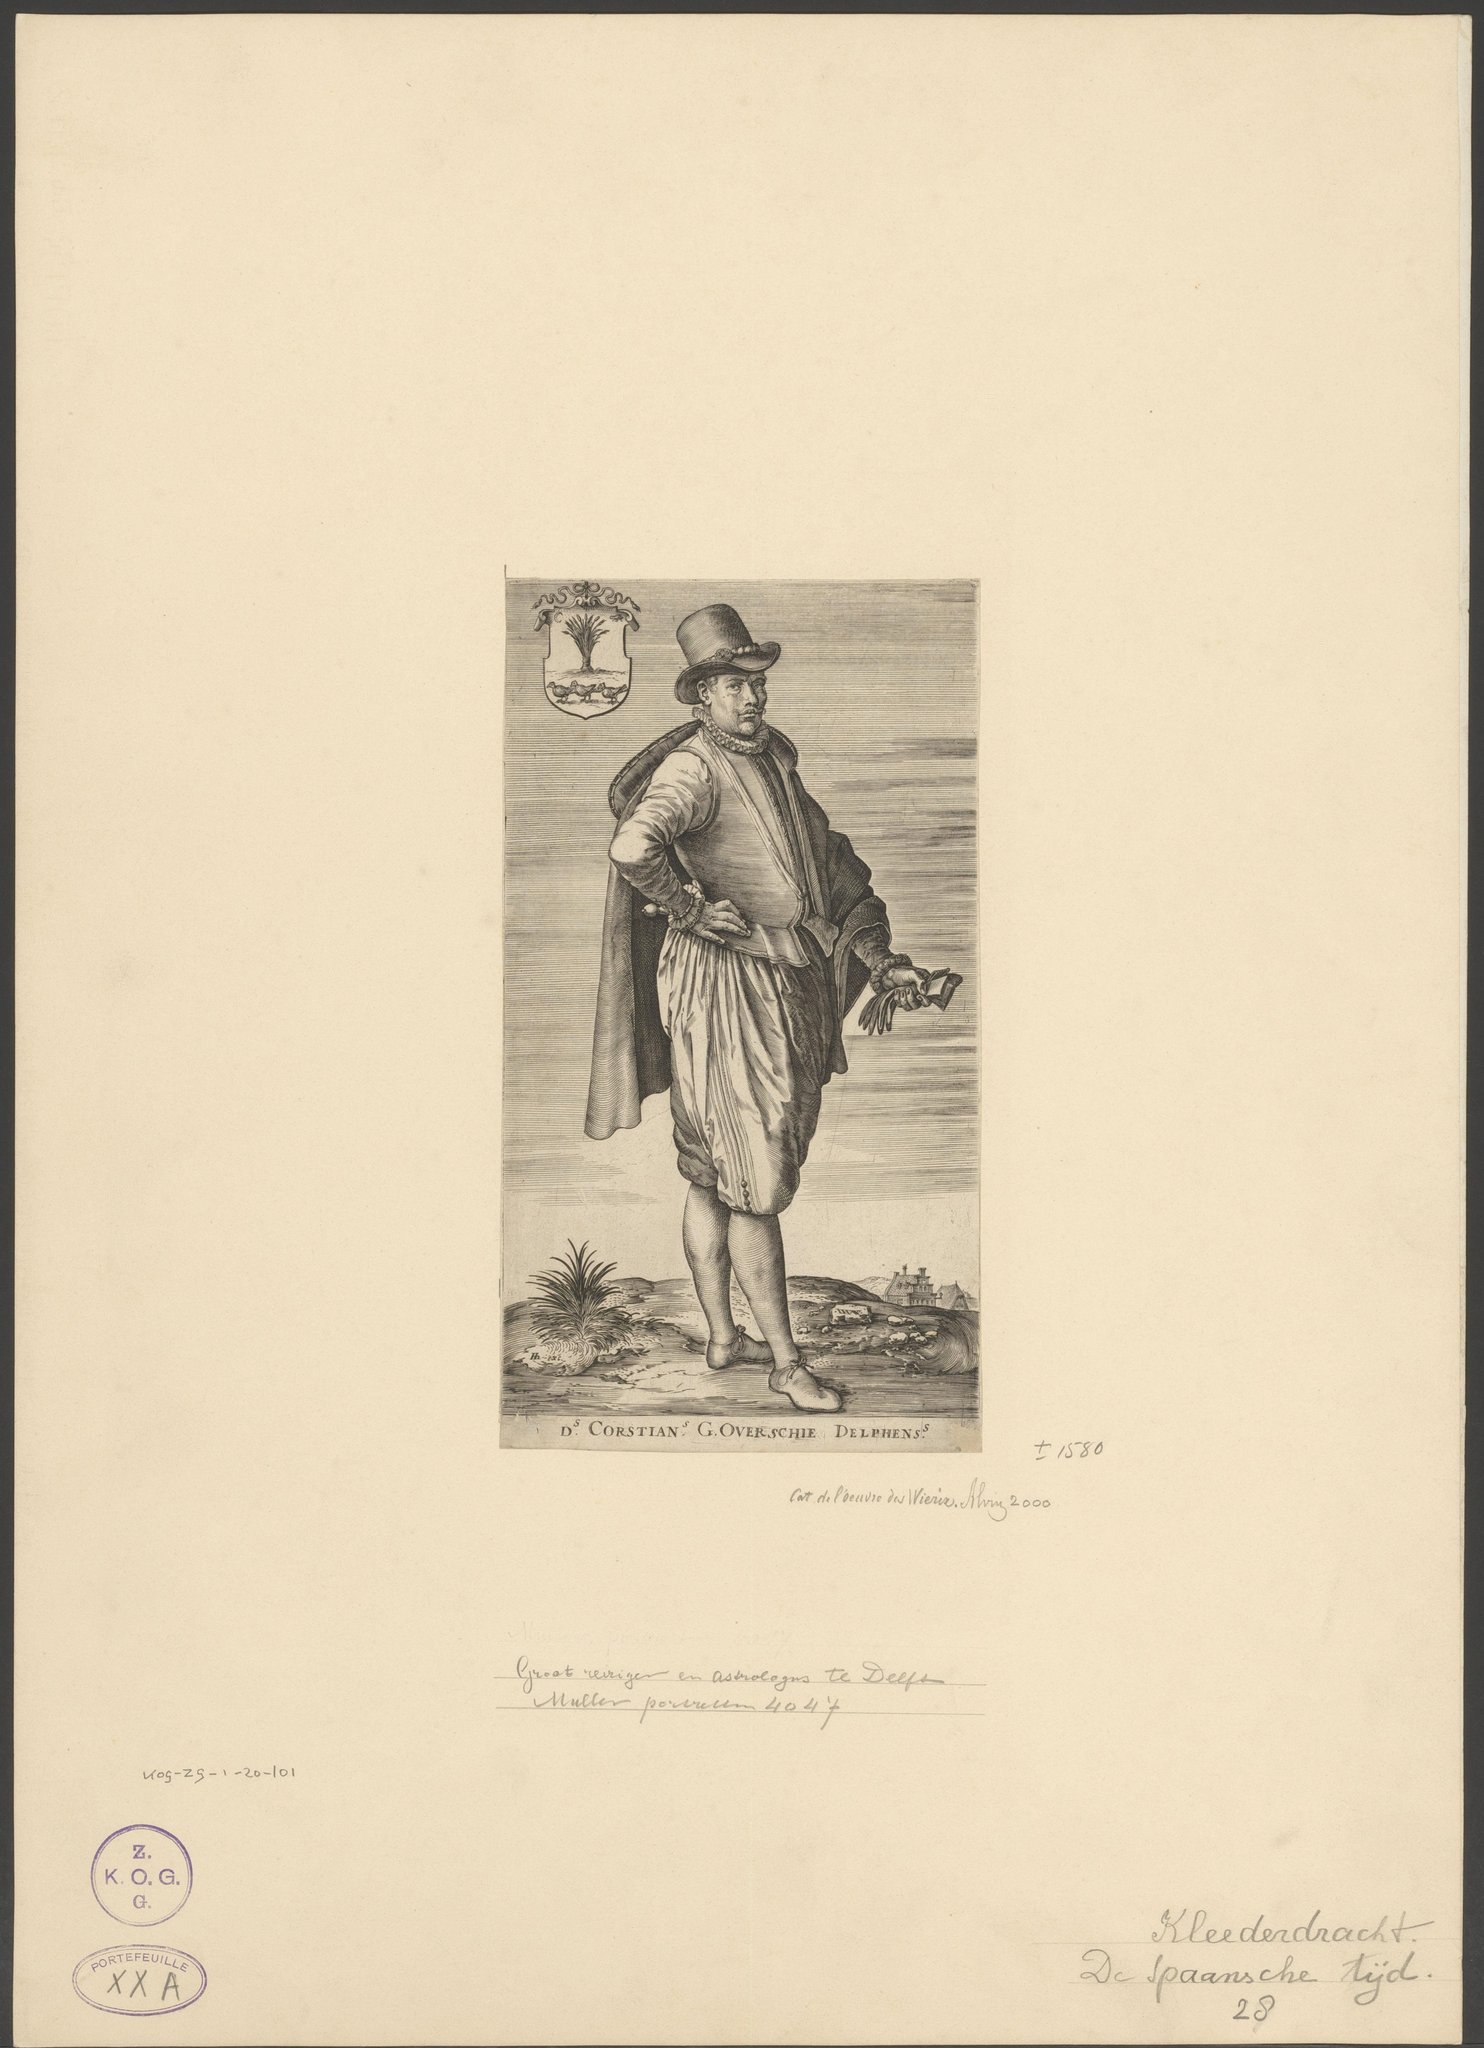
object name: print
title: Ds. Corstians G. Overschie Delphens.s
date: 1579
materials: paper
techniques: engraving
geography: the hague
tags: standing figure, cape (+ men's clothes), head-gear: hat (+ men's clothes), shoes, sandals (+ men's clothes), clothes, costume (+ men's clothes), folk costume, regional costume, trousers, breeches, etc. (breeches) (+ men's clothes), clothing for the upper part of the body (doublet) (+ men's clothes), gloves, mittens, etc. (+ men's clothes), stockings, socks (+ men's clothes), sleeves (+ men's clothes), armorial bearing, heraldry, delft, overschie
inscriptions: collector's mark: Lugt 1641, collector's mark: Lugt 963, stamp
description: Portret van Corstianus G. Overschie, ten voeten uit, in de buitenlucht, een paar handschoenen in de hand. Linksboven zijn wapenschild. Onderwerpsrubrieken binnen de Atlas Zeden en Gewoonten: Zeden en Gewoonten in Engeren Zin, De Kleeding, Kleederdrachten (tijdvakken), De Spaansche tijd. (1550 – 1600).